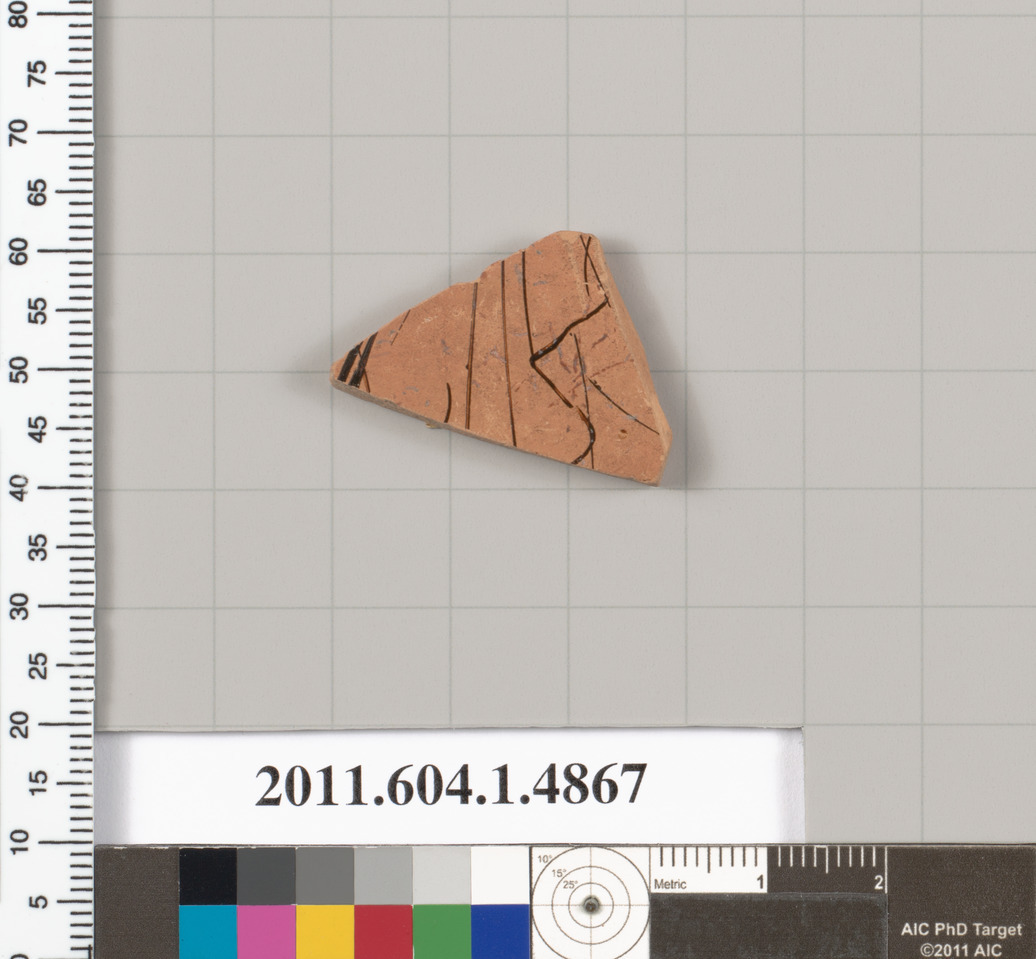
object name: kylix fragment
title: Terracotta fragment of a kylix (drinking cup)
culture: greek, attic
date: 475-451 BCE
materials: terracotta